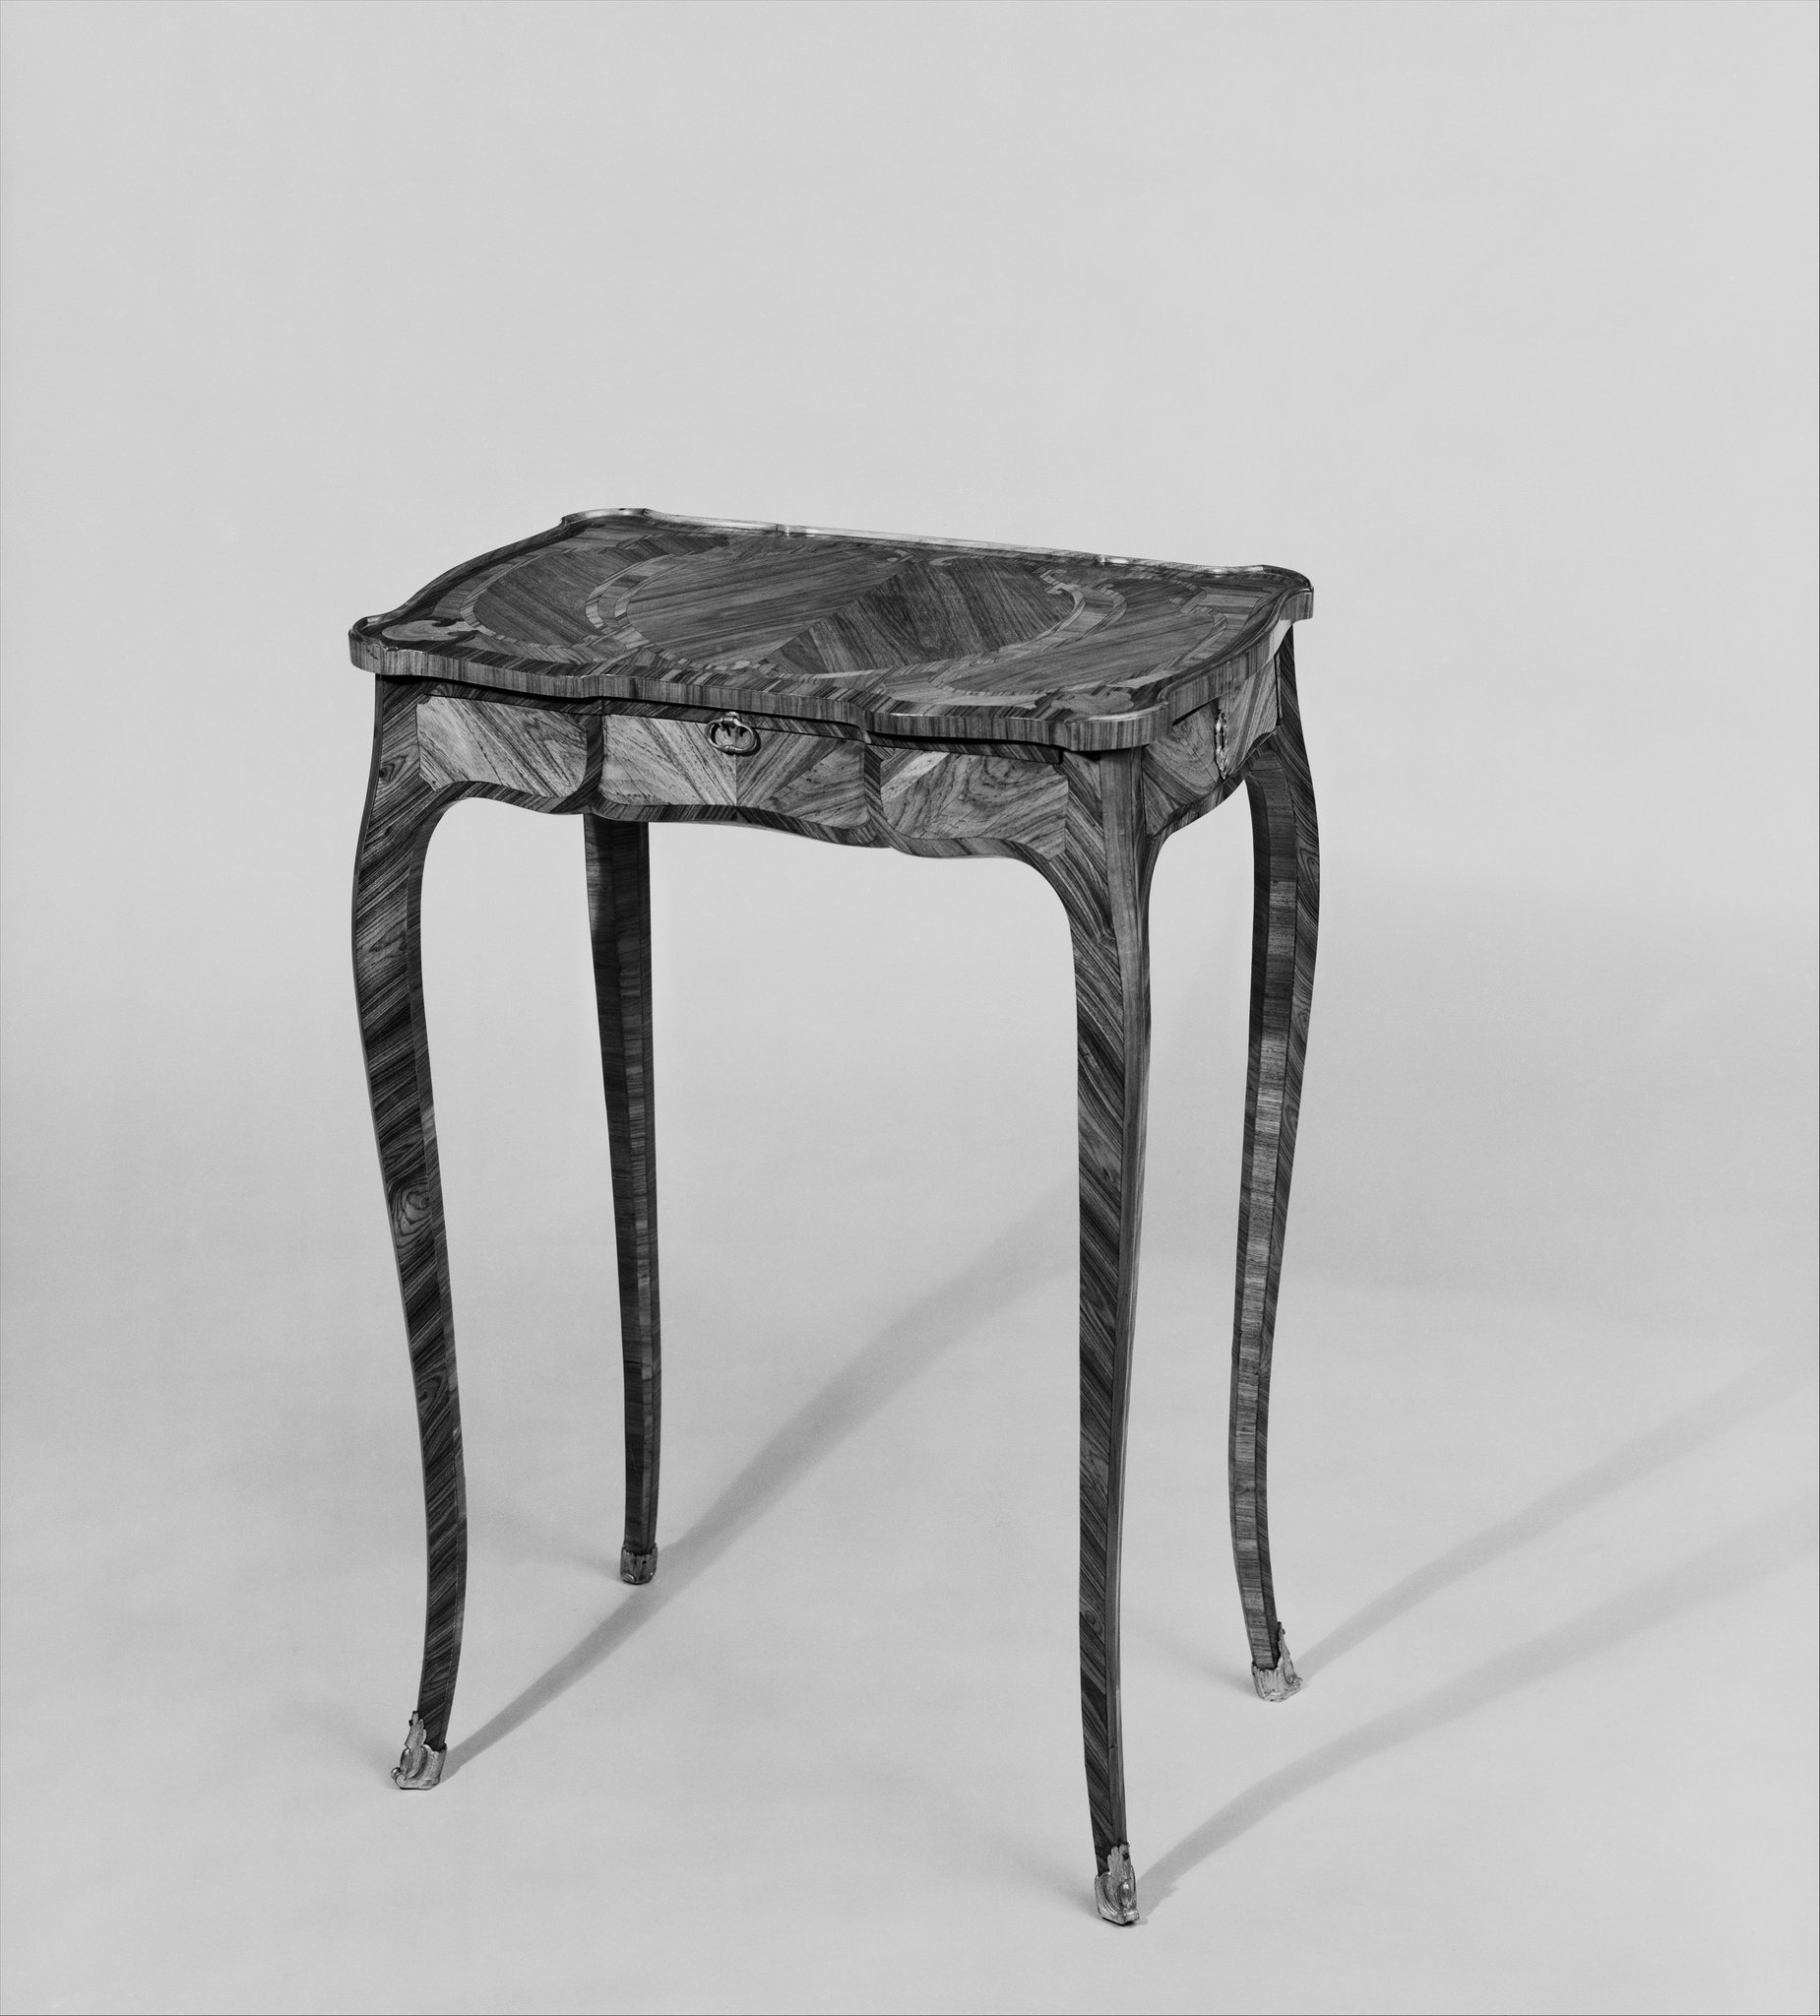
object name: table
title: Small rectangular table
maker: léonard boudin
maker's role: maker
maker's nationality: french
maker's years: 1735-1807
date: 1765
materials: brass, leather, wood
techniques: veneering